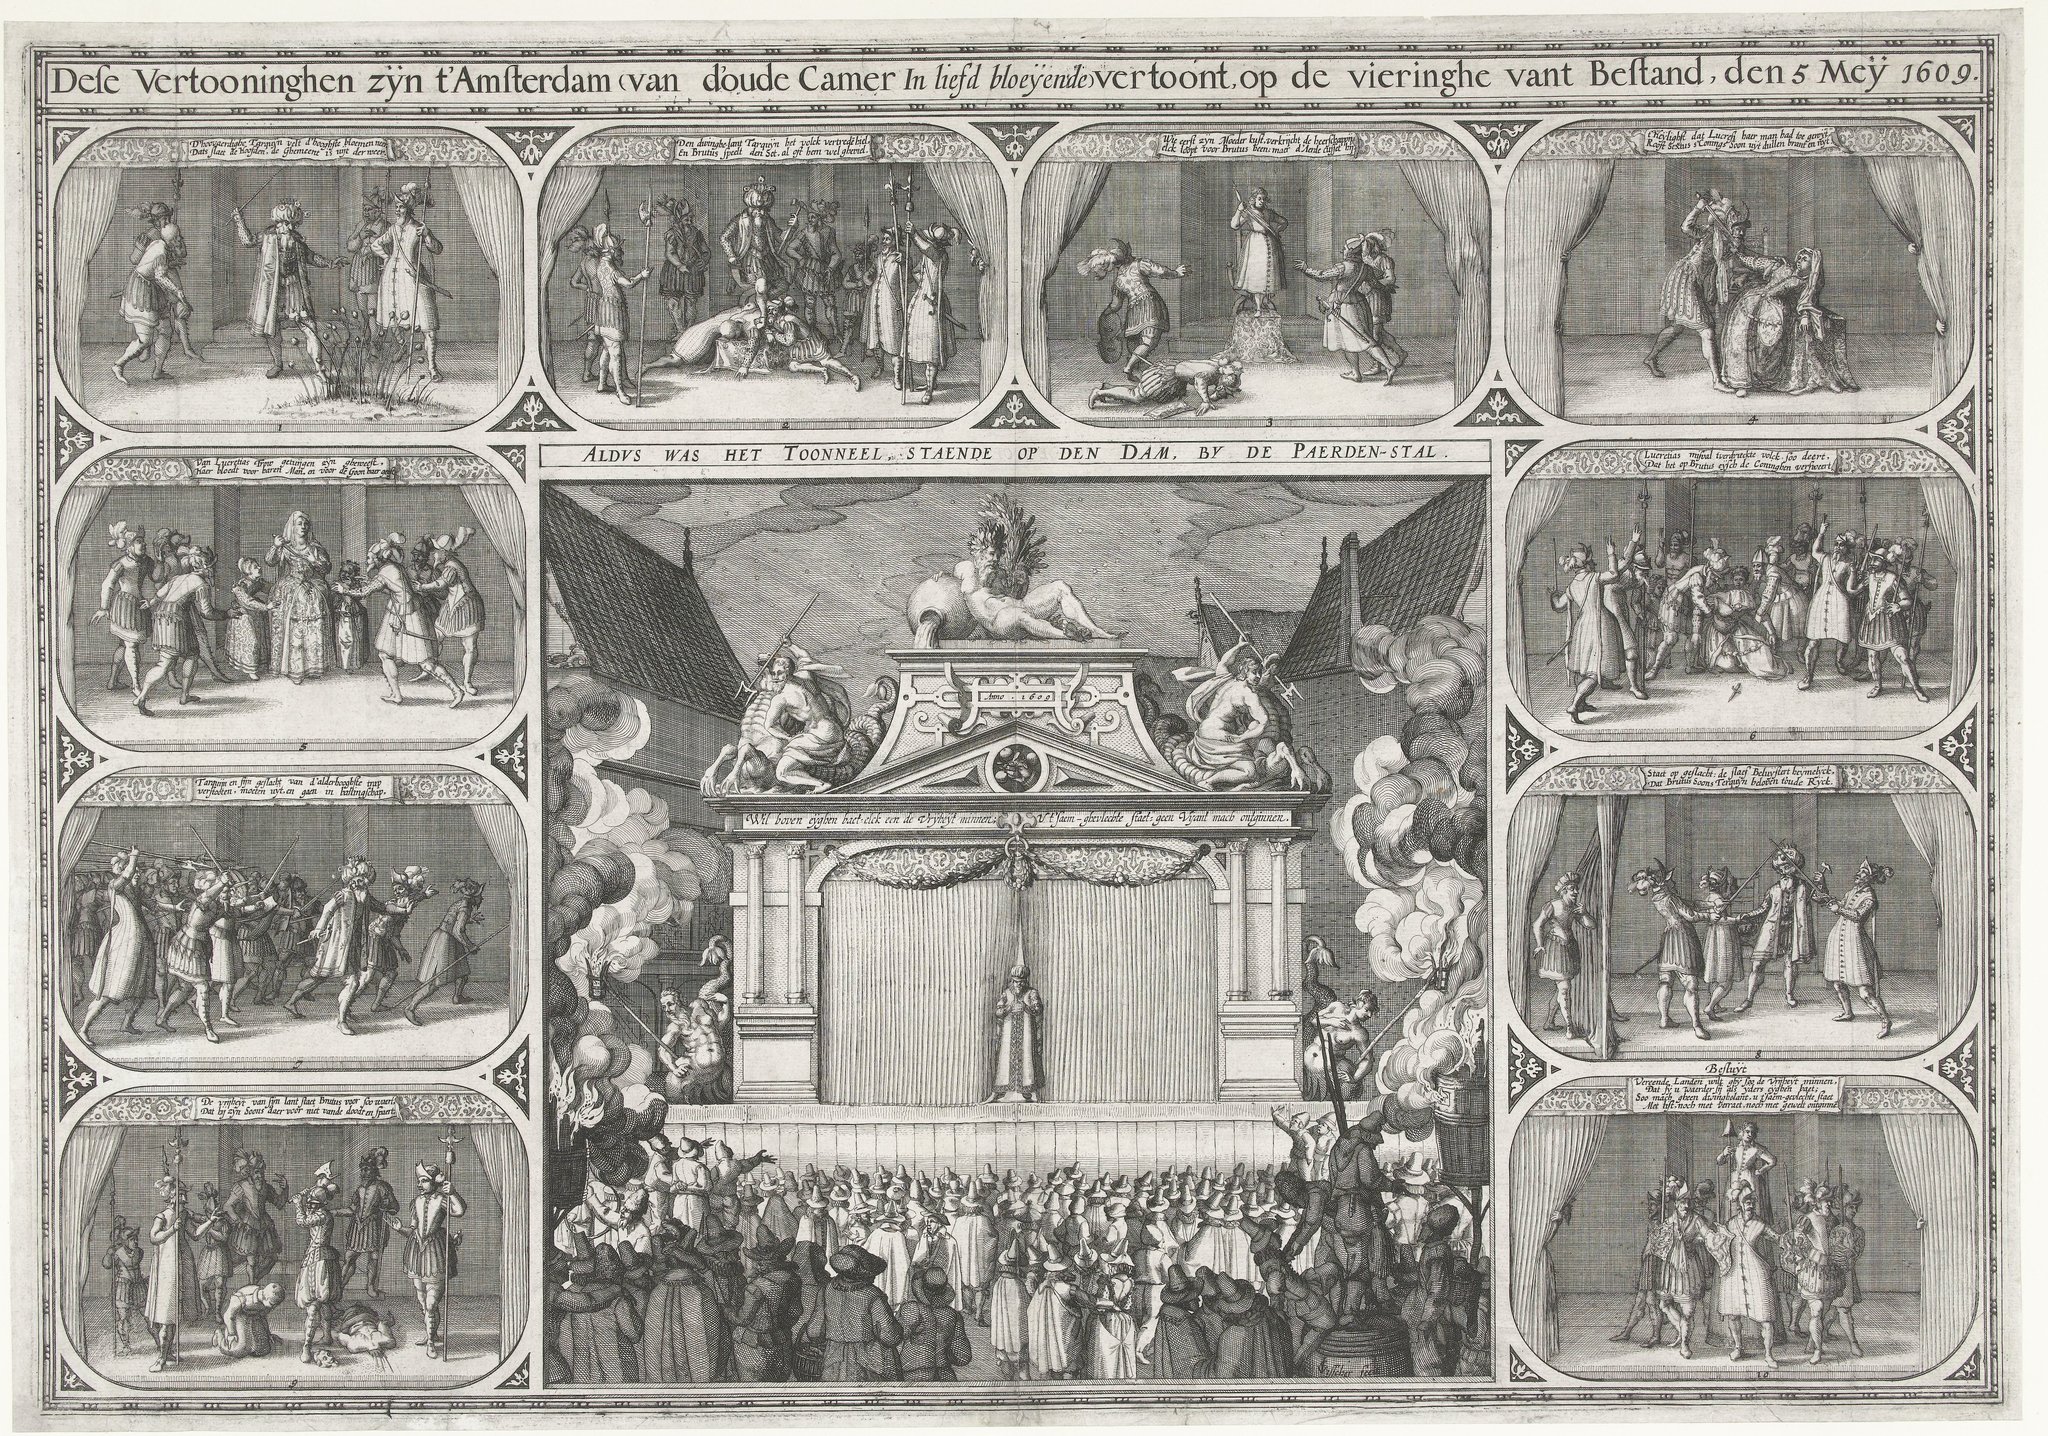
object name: print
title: Toneelspel op de Dam bij de viering van het Twaalfjarig Bestand, op 5 mei 1609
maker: claes jansz. visscher (ii)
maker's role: draughtsman, print maker, publisher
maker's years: 1586-1652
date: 1609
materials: paper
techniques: etching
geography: amsterdam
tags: theatre, theatrical performance, male persons from classical history (brutus), (story of) tarquinius superbus, (story of) lucretia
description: Uitvoering van een toneelscène geschreven door P.C. Hooft door de Amsterdamse rederijkerskamer De Eglentier op de Dam bij de viering van het Twaalfjarig Bestand op 5 mei 1609. In het midden een grote voorstelling van het toneel met decor en publiek. Hieromheen negen kleinere taferelen ontleend aan de historie van Lucretia, Tarquinius en Brutus, elk met een tweeregelig vers. De laatste voorstelling toont de Vrijheid omringd en beschermd door de zeven provincies.